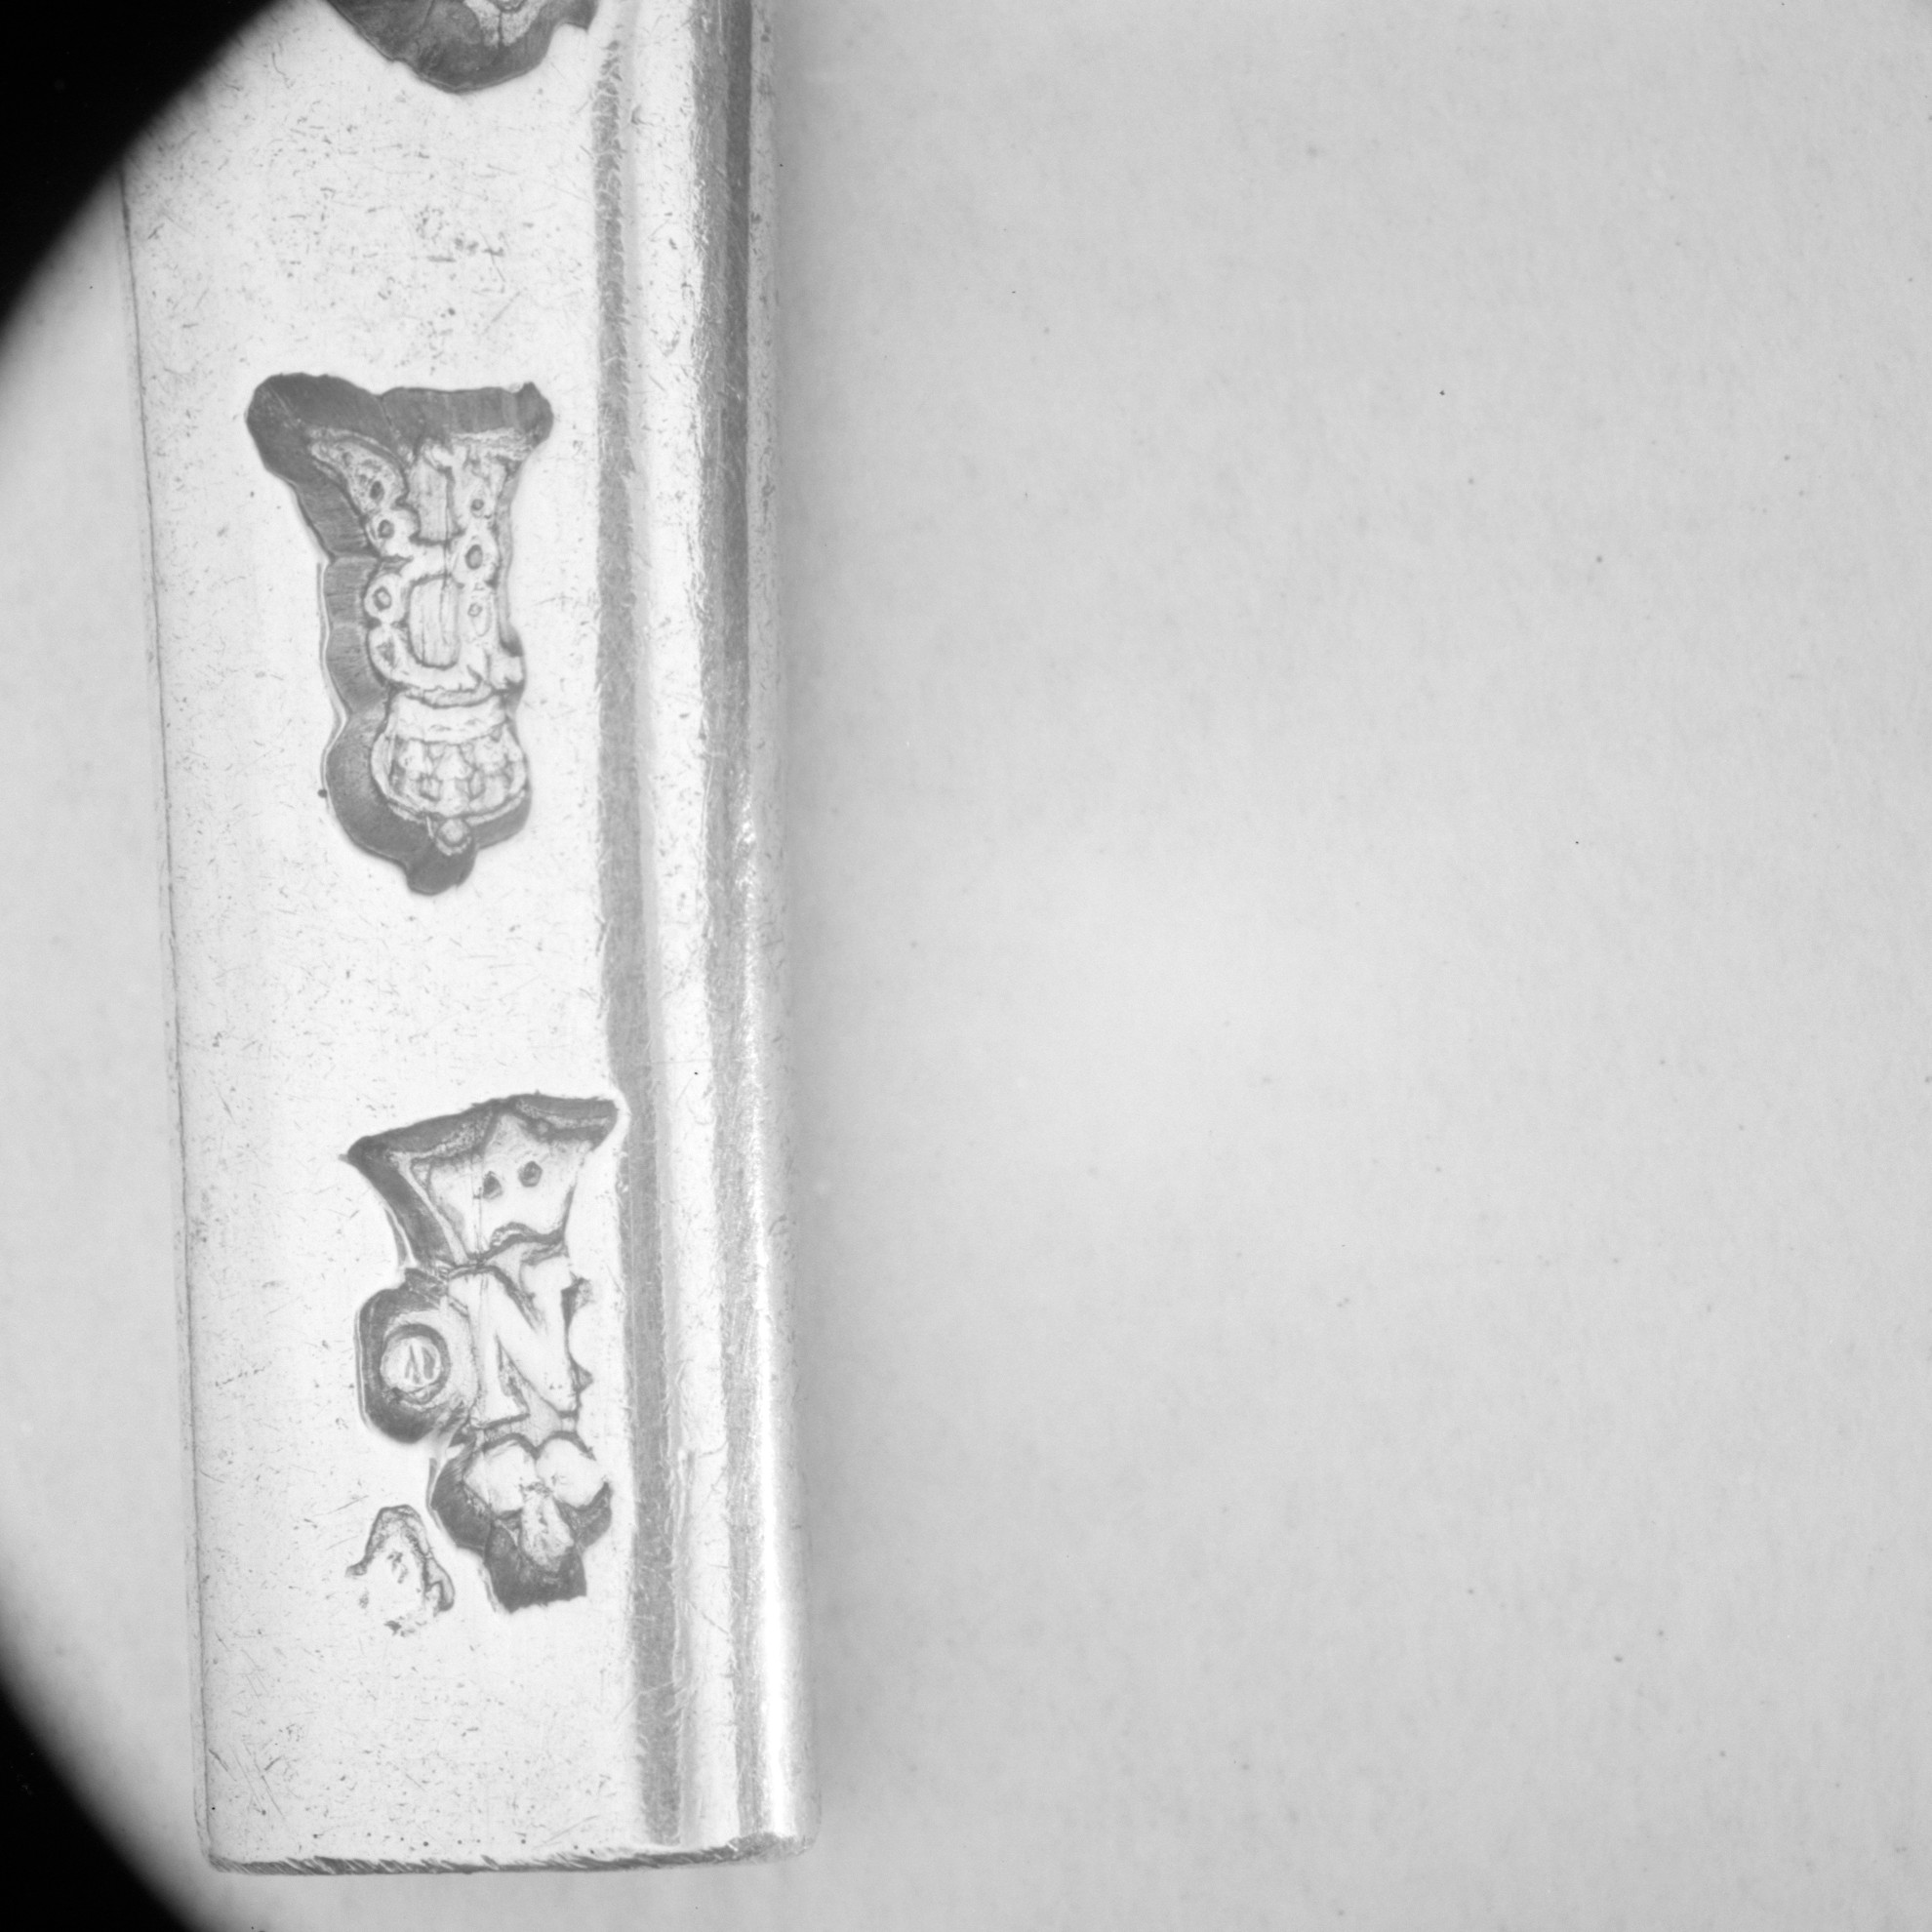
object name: spoon handle section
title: Section of a spoon handle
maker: p. b., orleans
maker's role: maker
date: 1780-1782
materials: silver